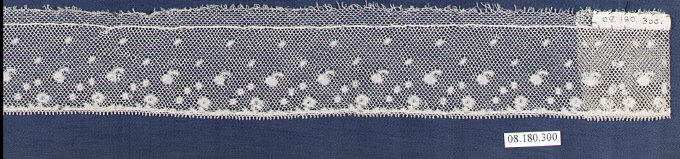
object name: piece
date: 1801-1833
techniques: lace